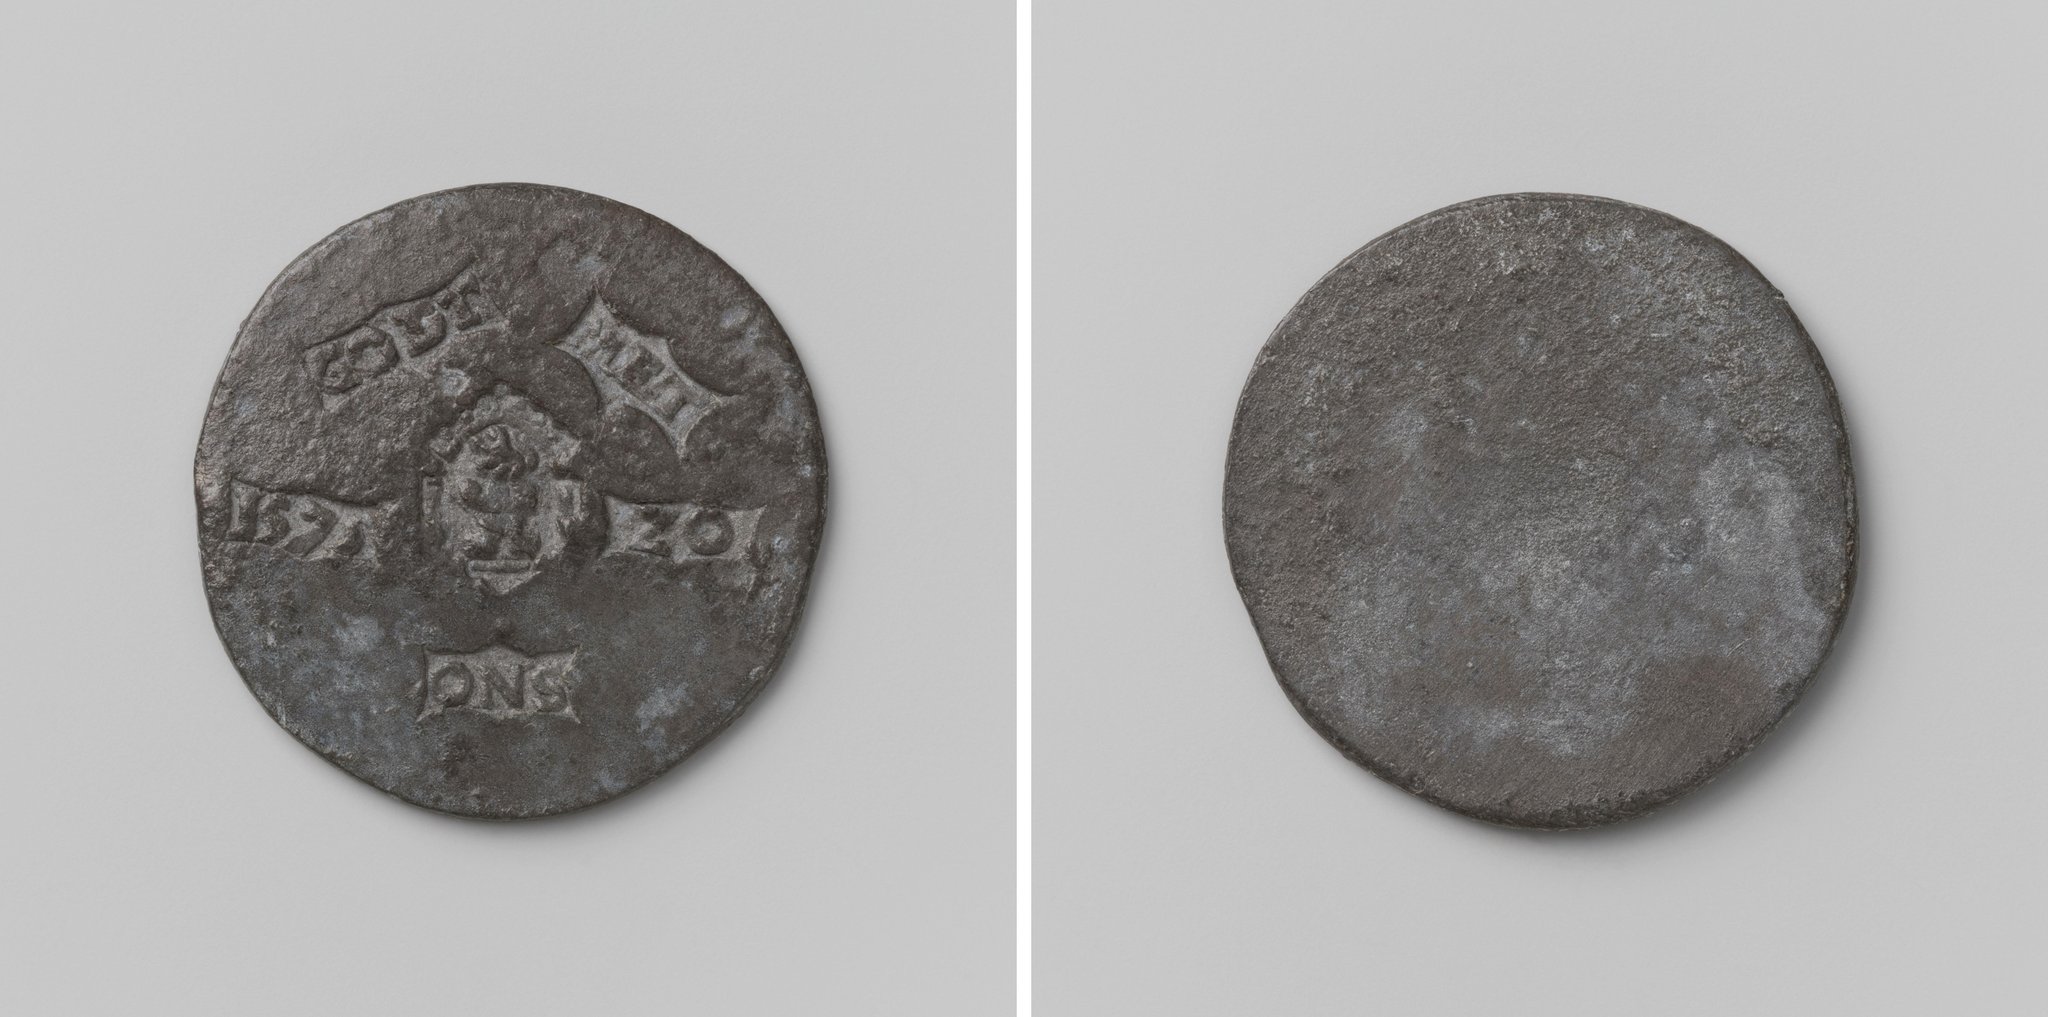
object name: siege coin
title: Twintig stuiver, noodmunt uit Oudewater, ter betaling van het garnizoen dat de stad verdedigde tijdens het beleg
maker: Anonymous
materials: tin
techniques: striking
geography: oudewater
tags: oudewater, tachtigjarige oorlog, beleg van oudewater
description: eenzijdige noodmunt. Voorzijde: zes stempels: rondom wapenschild opschrift bestaande uit drie verschillende stempels; jaartal en cijfer 20. Keerzijde: blanco